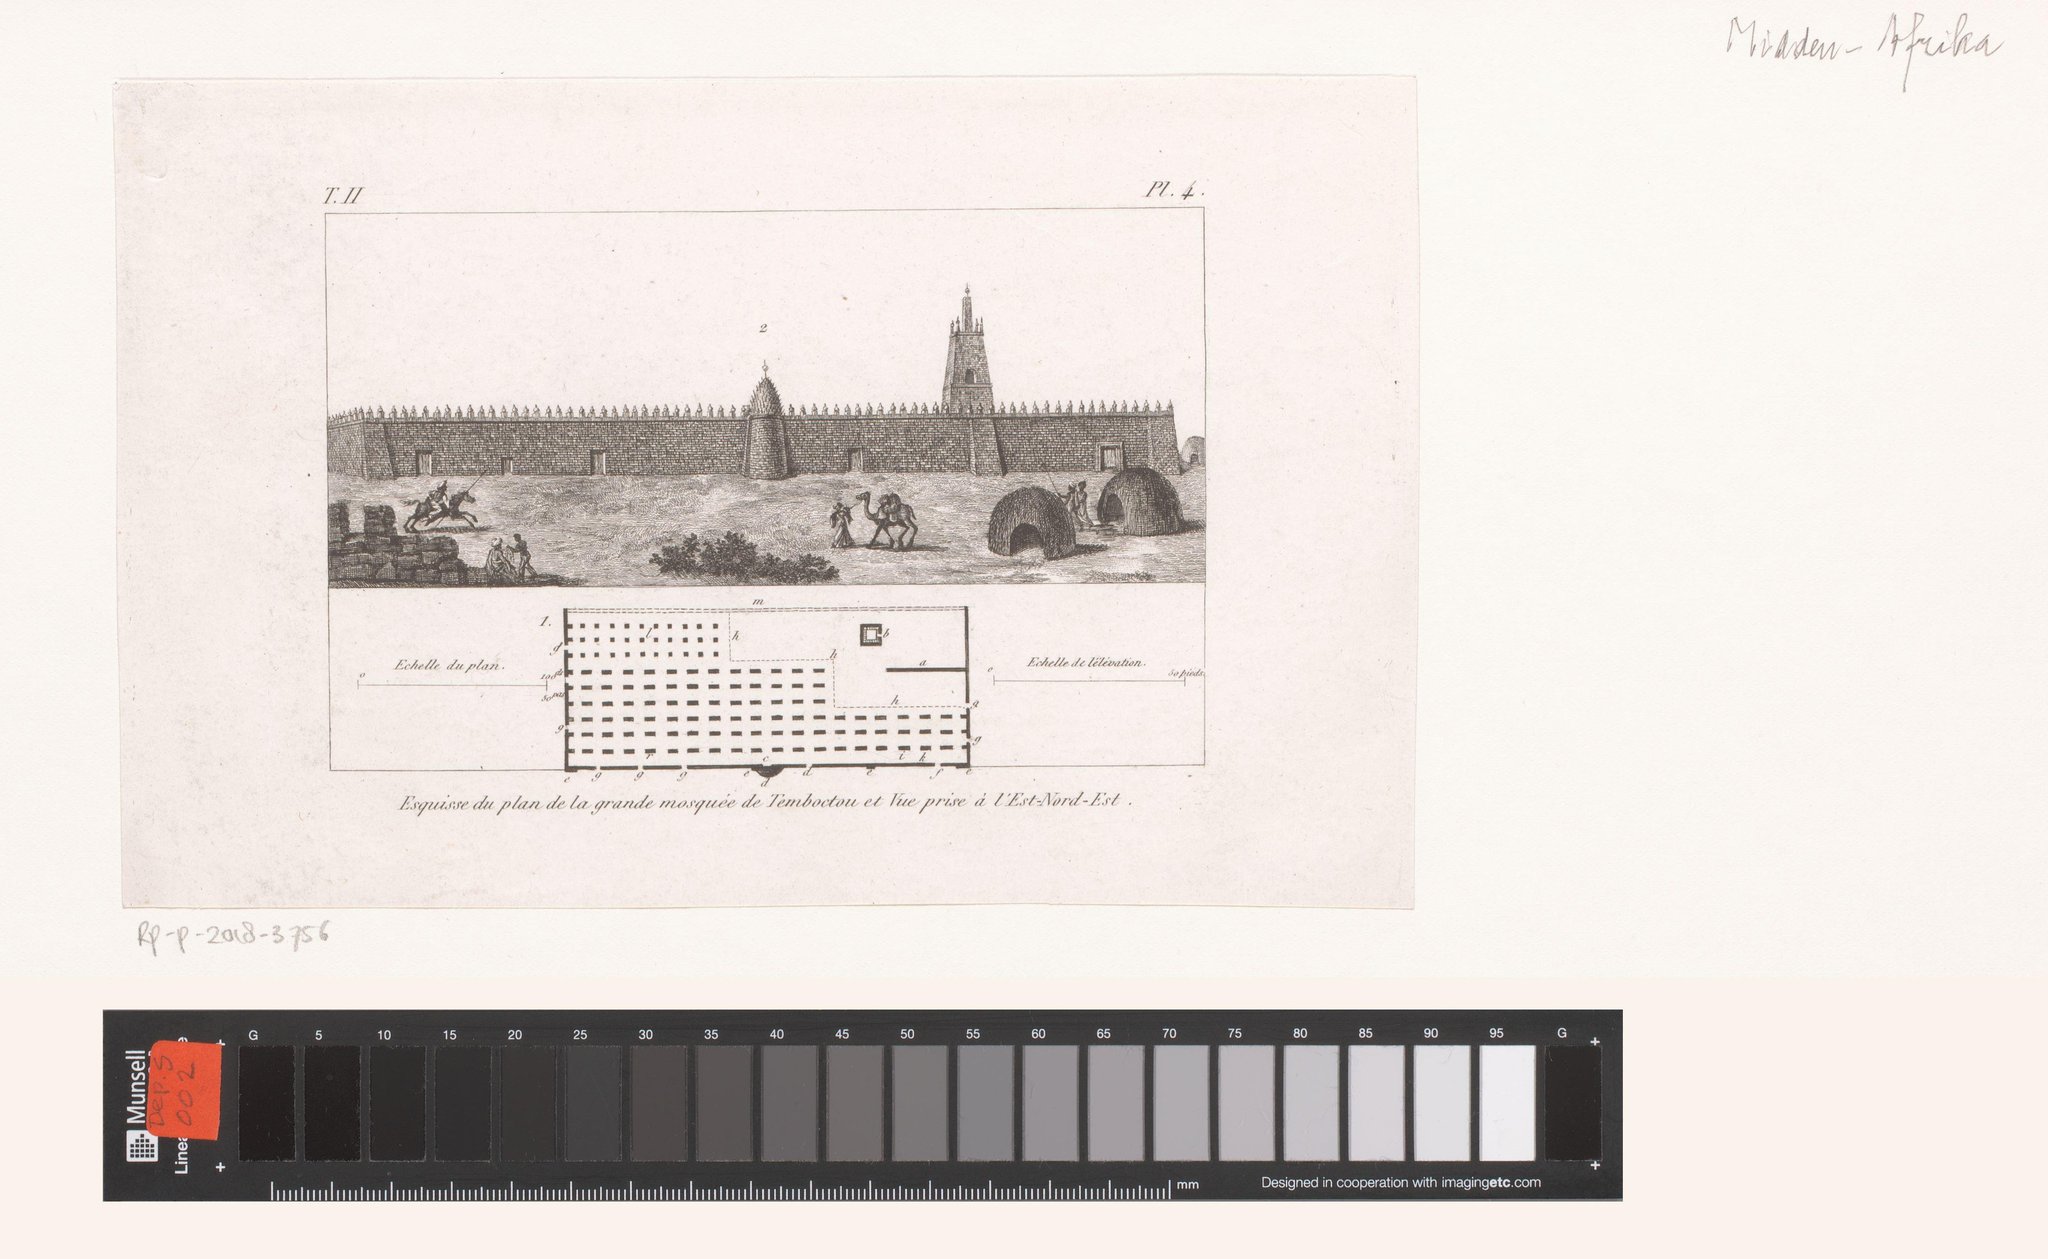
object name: area plan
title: Gezicht op en plattegrond van de Djinguereber-moskee te Timboektoe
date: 1830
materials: paper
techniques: etching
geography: paris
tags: temple, shrine ~ islam, mohammedanism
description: Prent uit: Caillié, René. Journal d'un voyage a Temboctou et a Jenné, dans l'Afrique centrale. Parijs: Pierre Mongie et al., 1830, dl. 2.